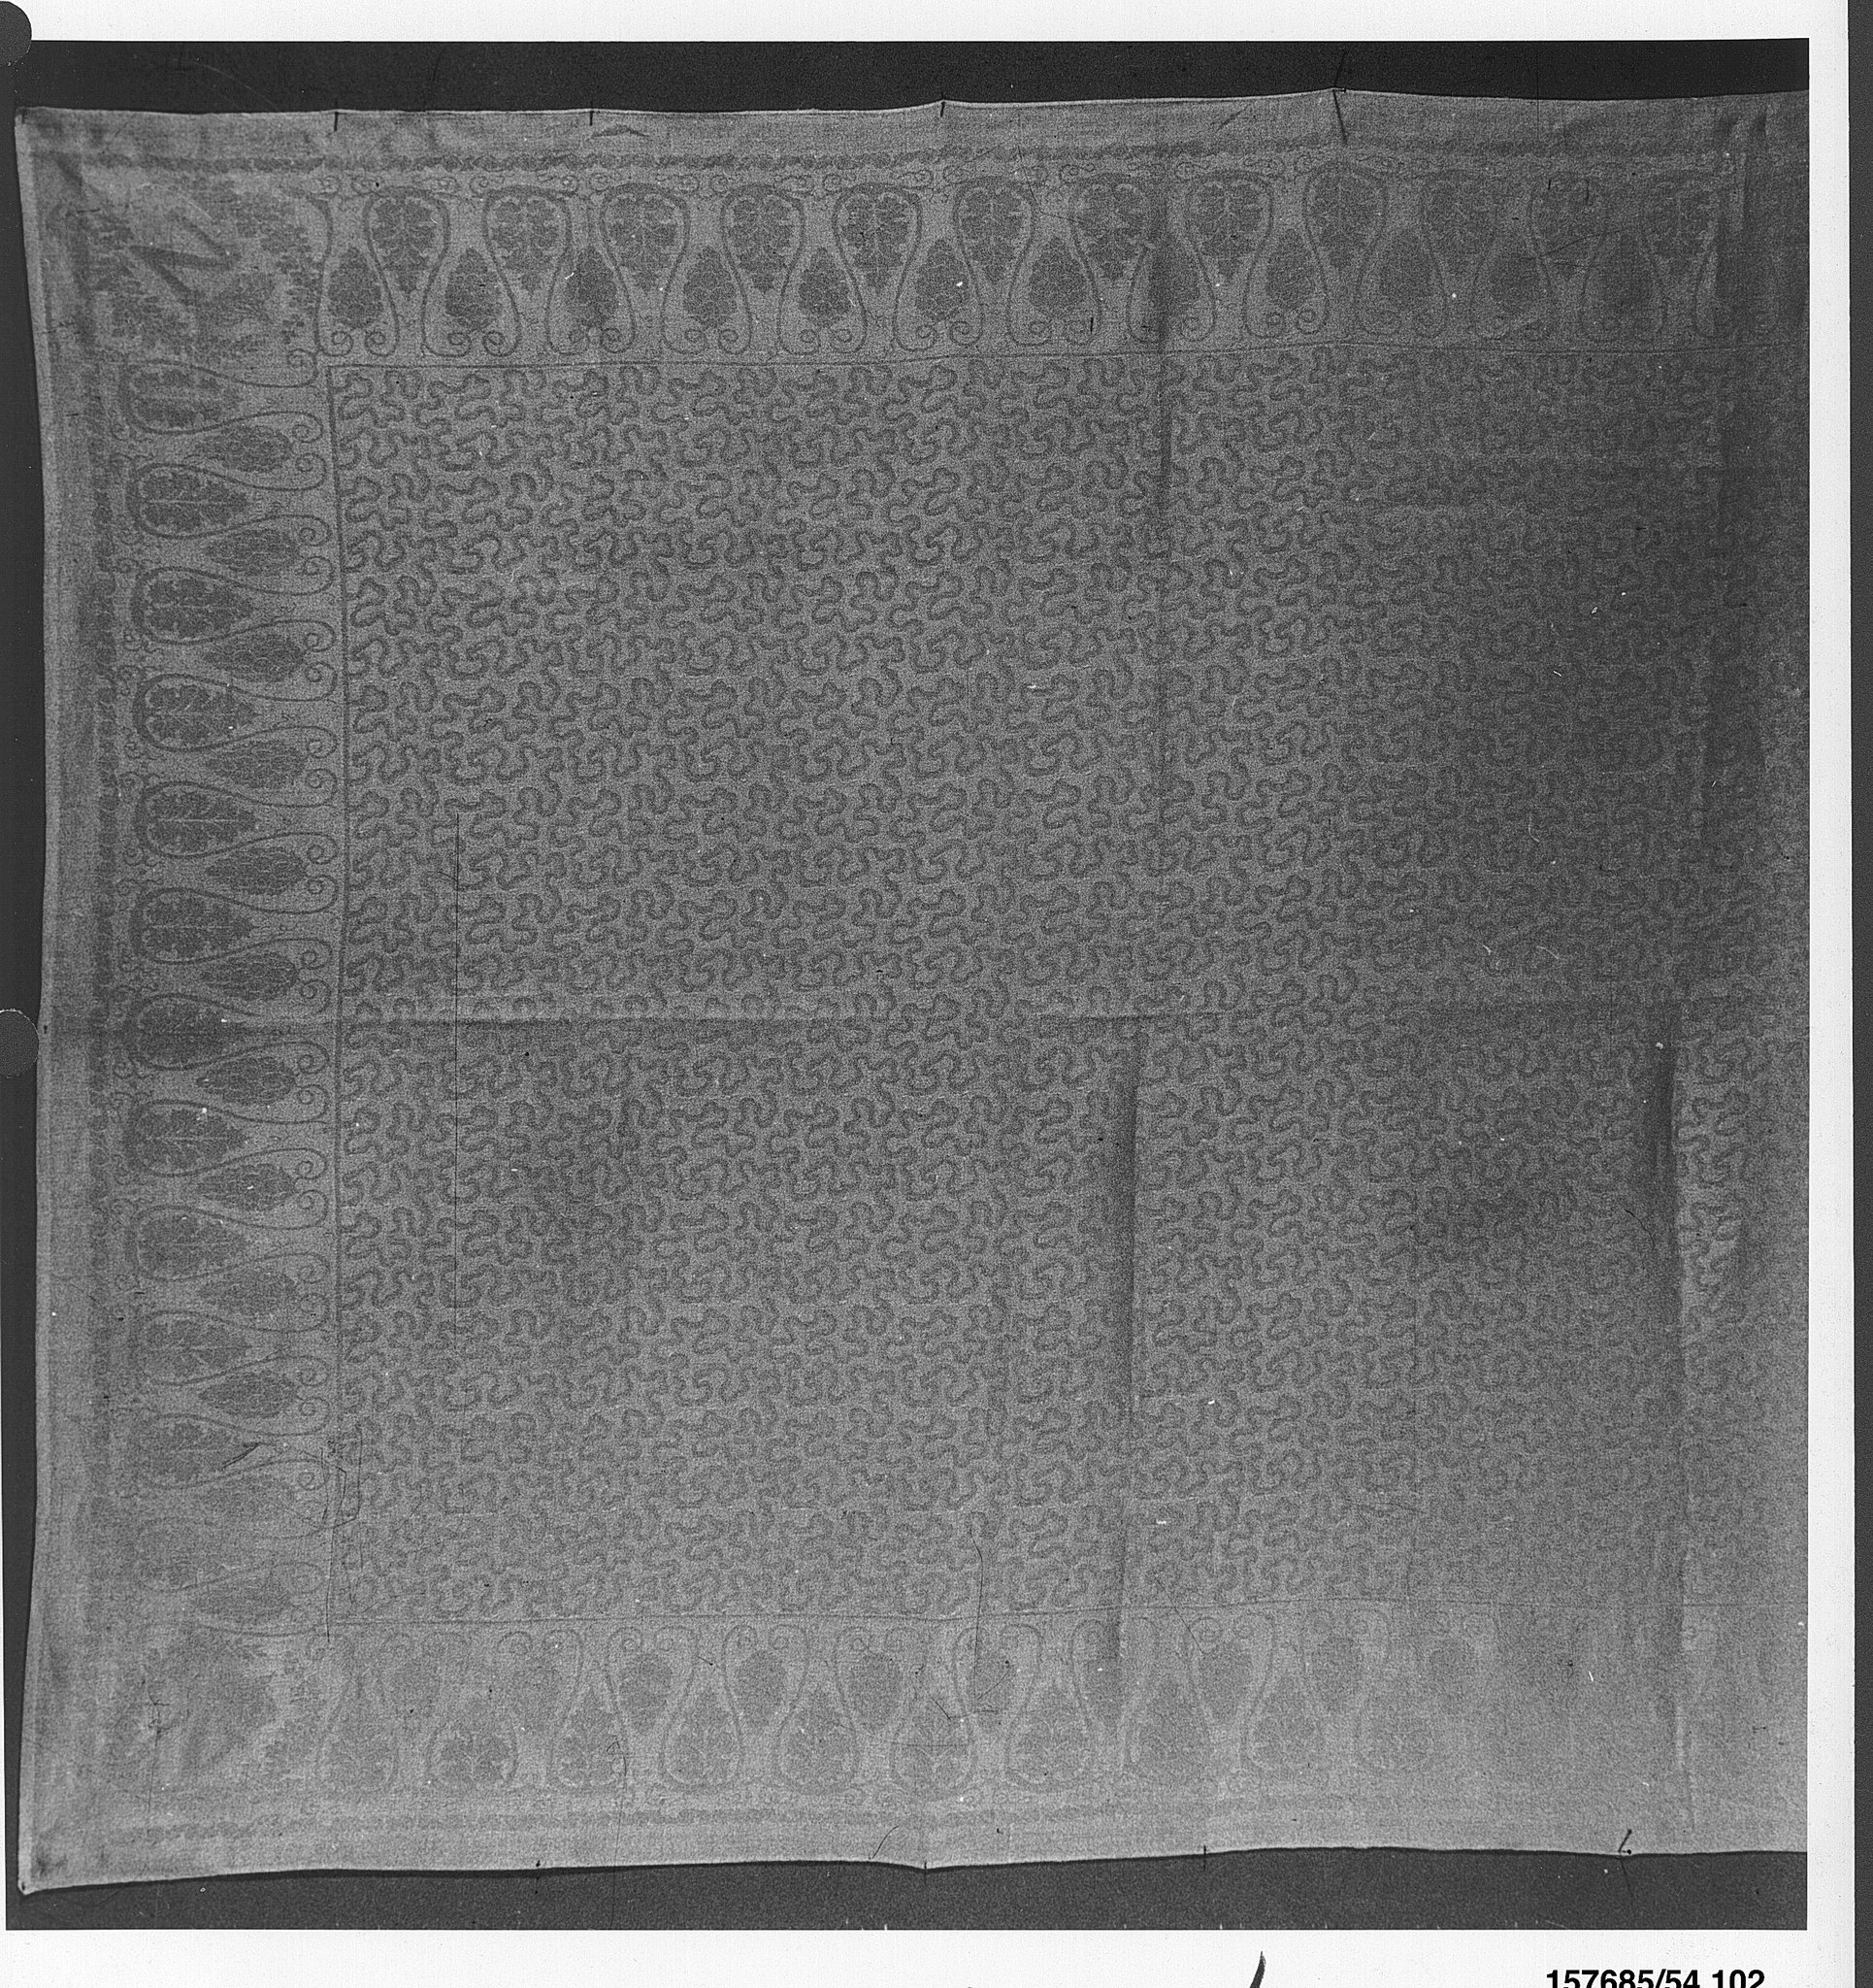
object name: napkin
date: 1852-1870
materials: linen